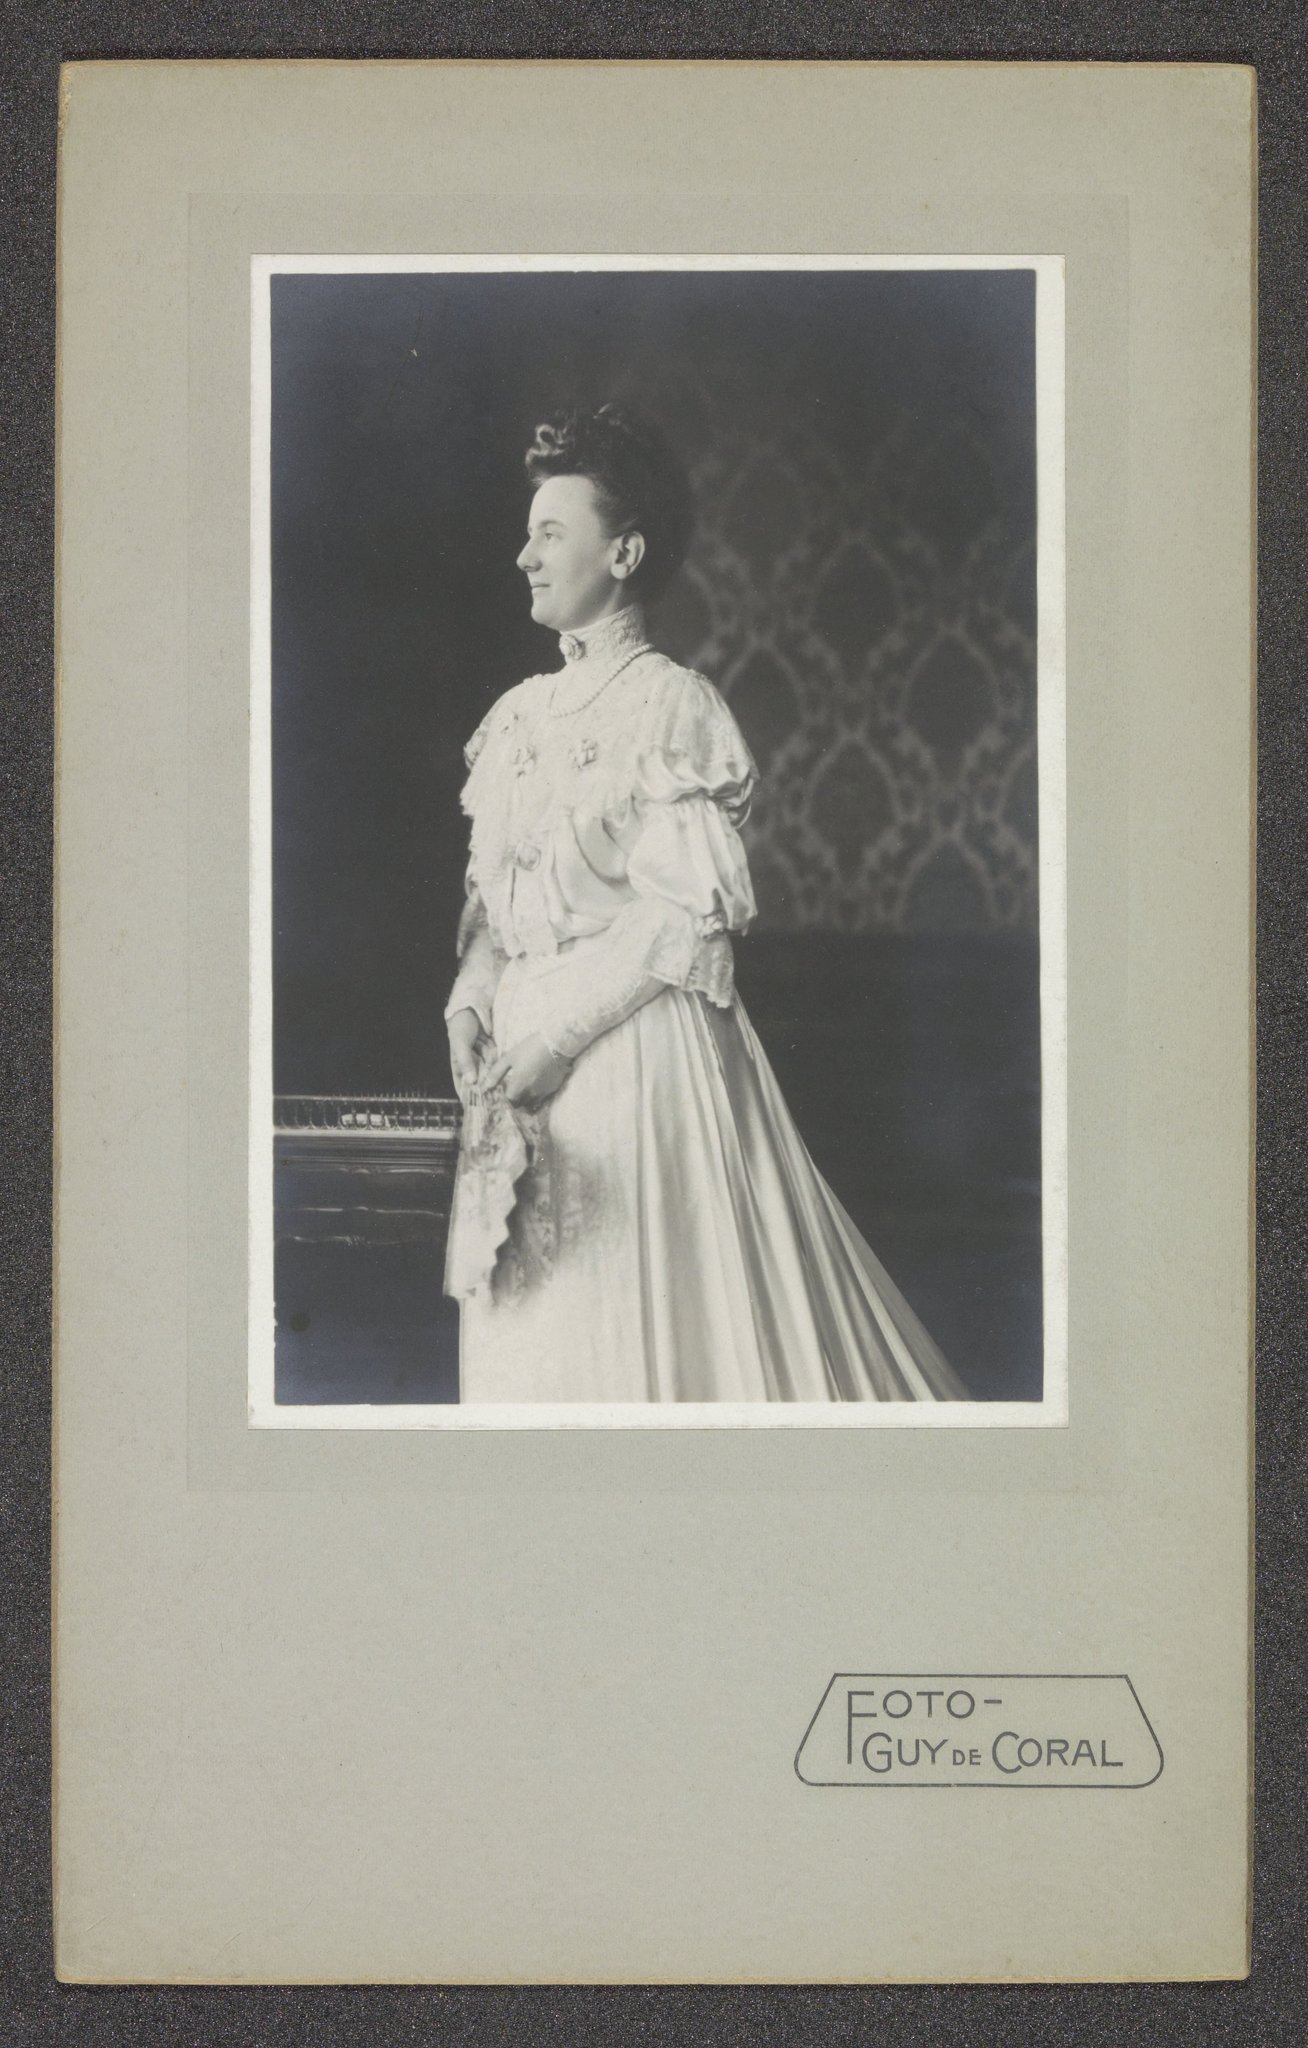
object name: photograph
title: Portret van jeugdige koningin Wilhelmina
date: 1905-1912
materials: photographic support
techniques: gelatin silver print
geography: the hague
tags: the hague, print maker, wilhelmina of the netherlands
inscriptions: stamp: ‘N.V. Amsterdamsche Boekhandel P.C. Hooftstraat 125 b/ Tramhalte van Baerlestraat’, name: ‘Origineele opname van Mij v/h Guy de Coral & Co foto artikelen Amsterdam, Den Haag Groningen’